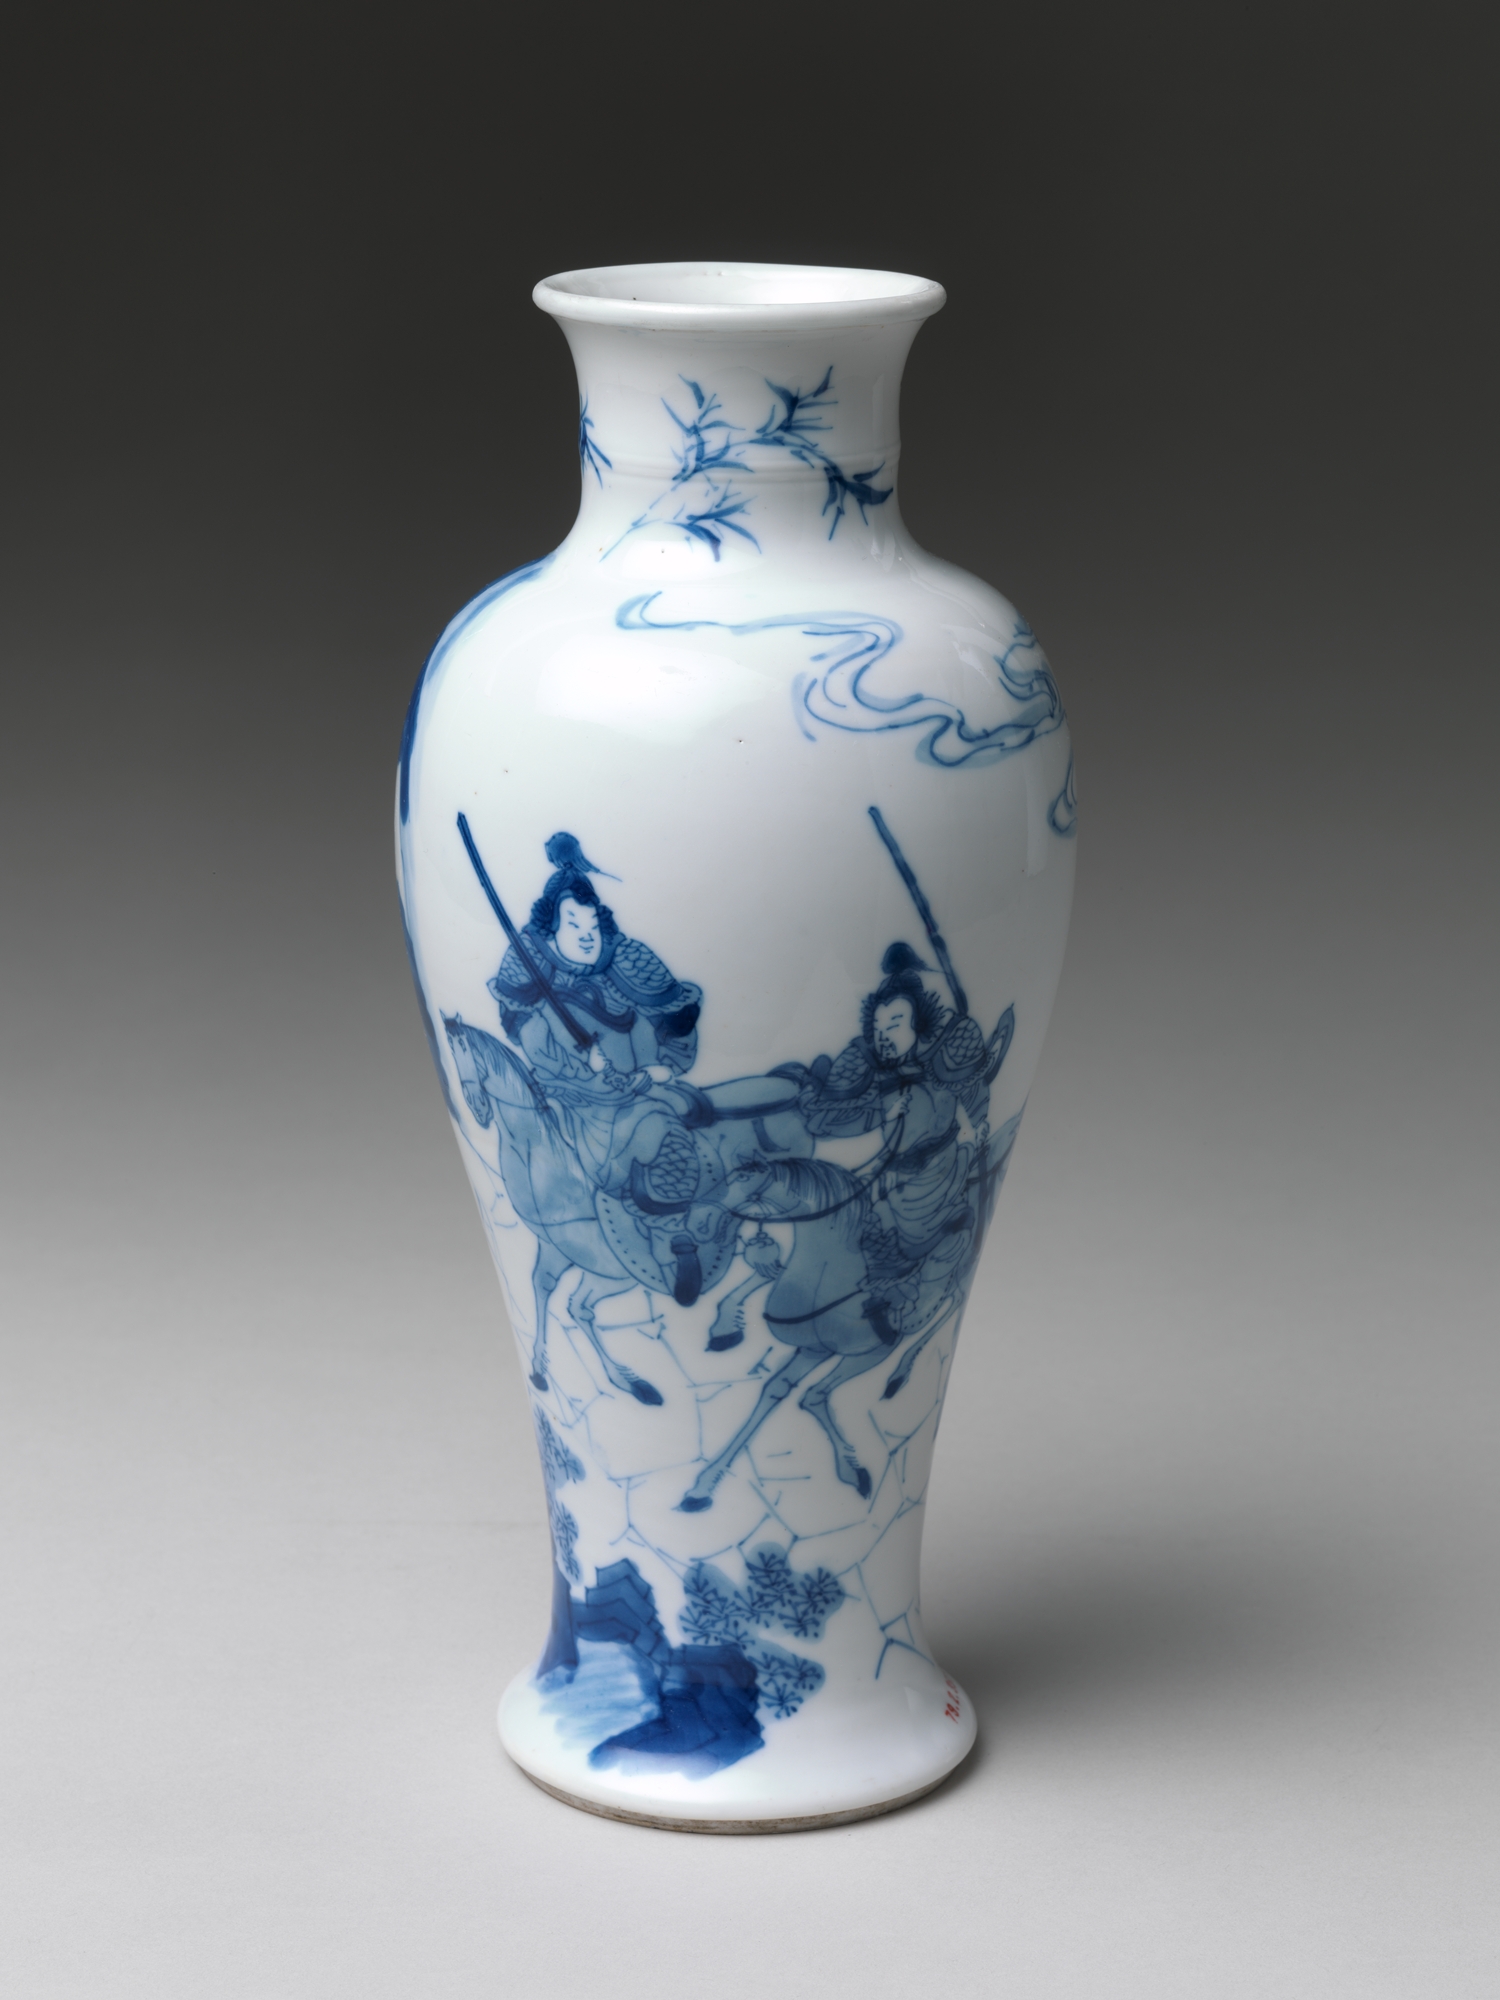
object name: vase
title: Vase with Warrior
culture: chinese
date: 1667-1700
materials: cobalt, glaze, porcelain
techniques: painting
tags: swords,men,horses